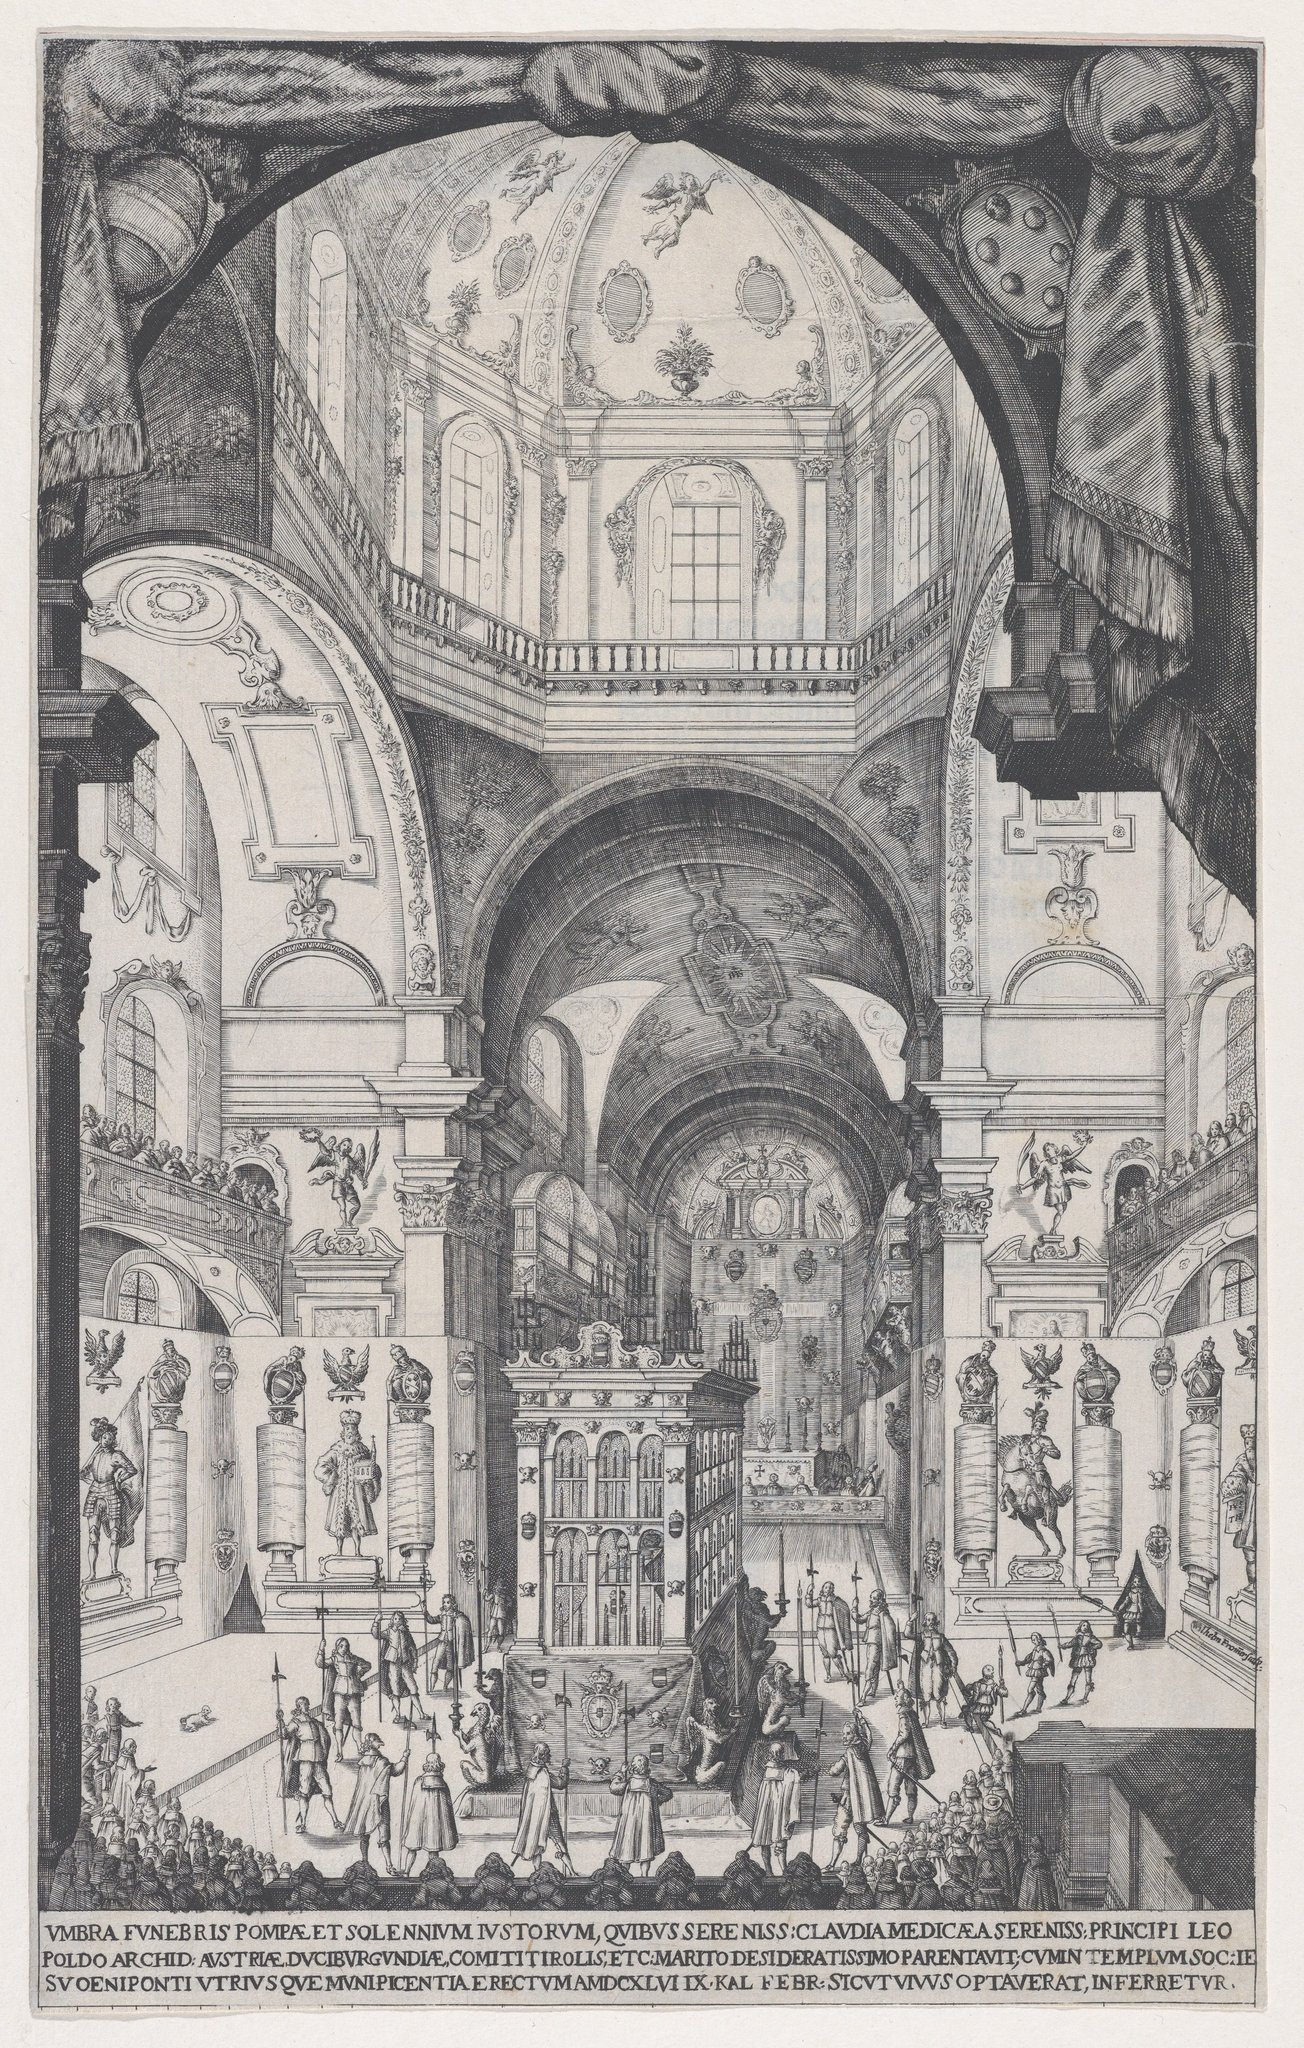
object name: print, fete, ornament architecture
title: Catafalque of Leopold, Archduke of Austria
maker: wilhelm frommer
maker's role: artist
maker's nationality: german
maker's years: 1618-1687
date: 1646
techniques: engraving, etching